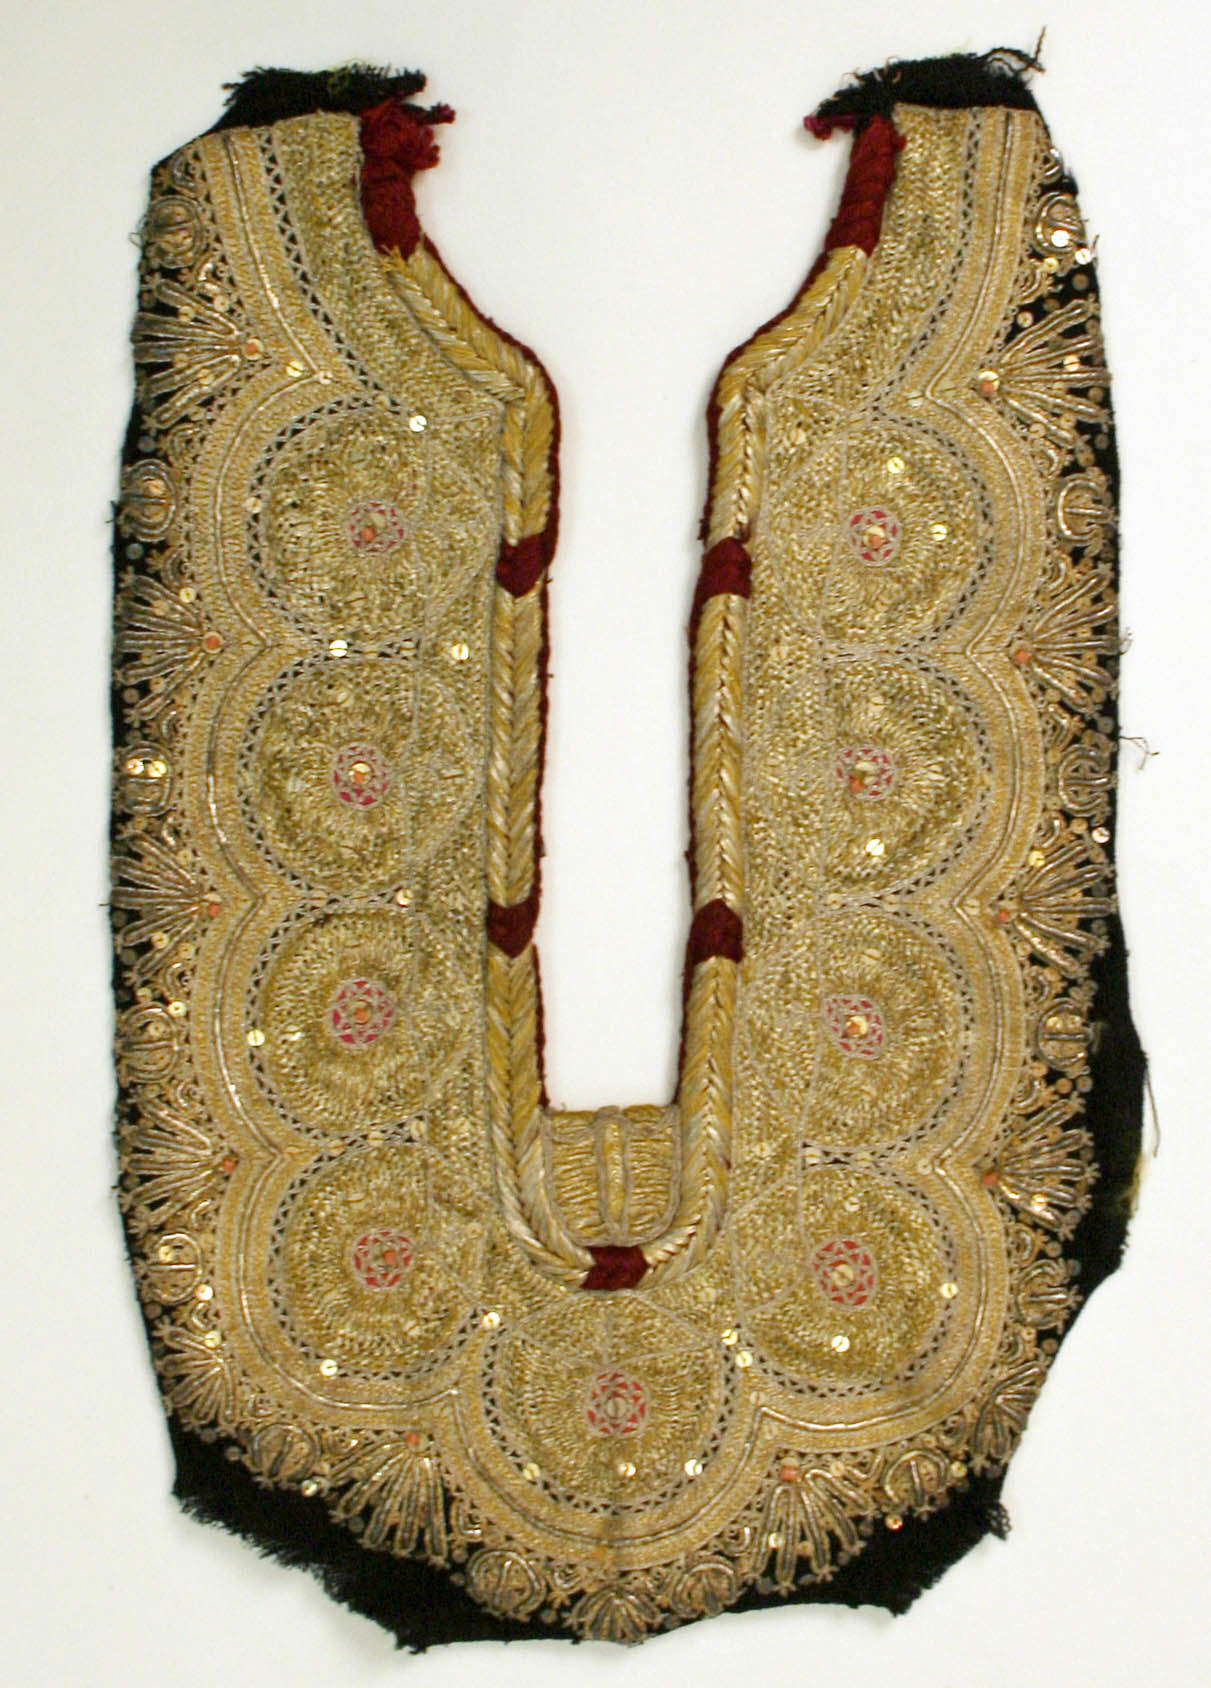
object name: tunic fragment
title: Plastron (Collar) from a Tunic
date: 1801-1900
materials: glass, metal thread, wool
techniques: embroidery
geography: tunisia